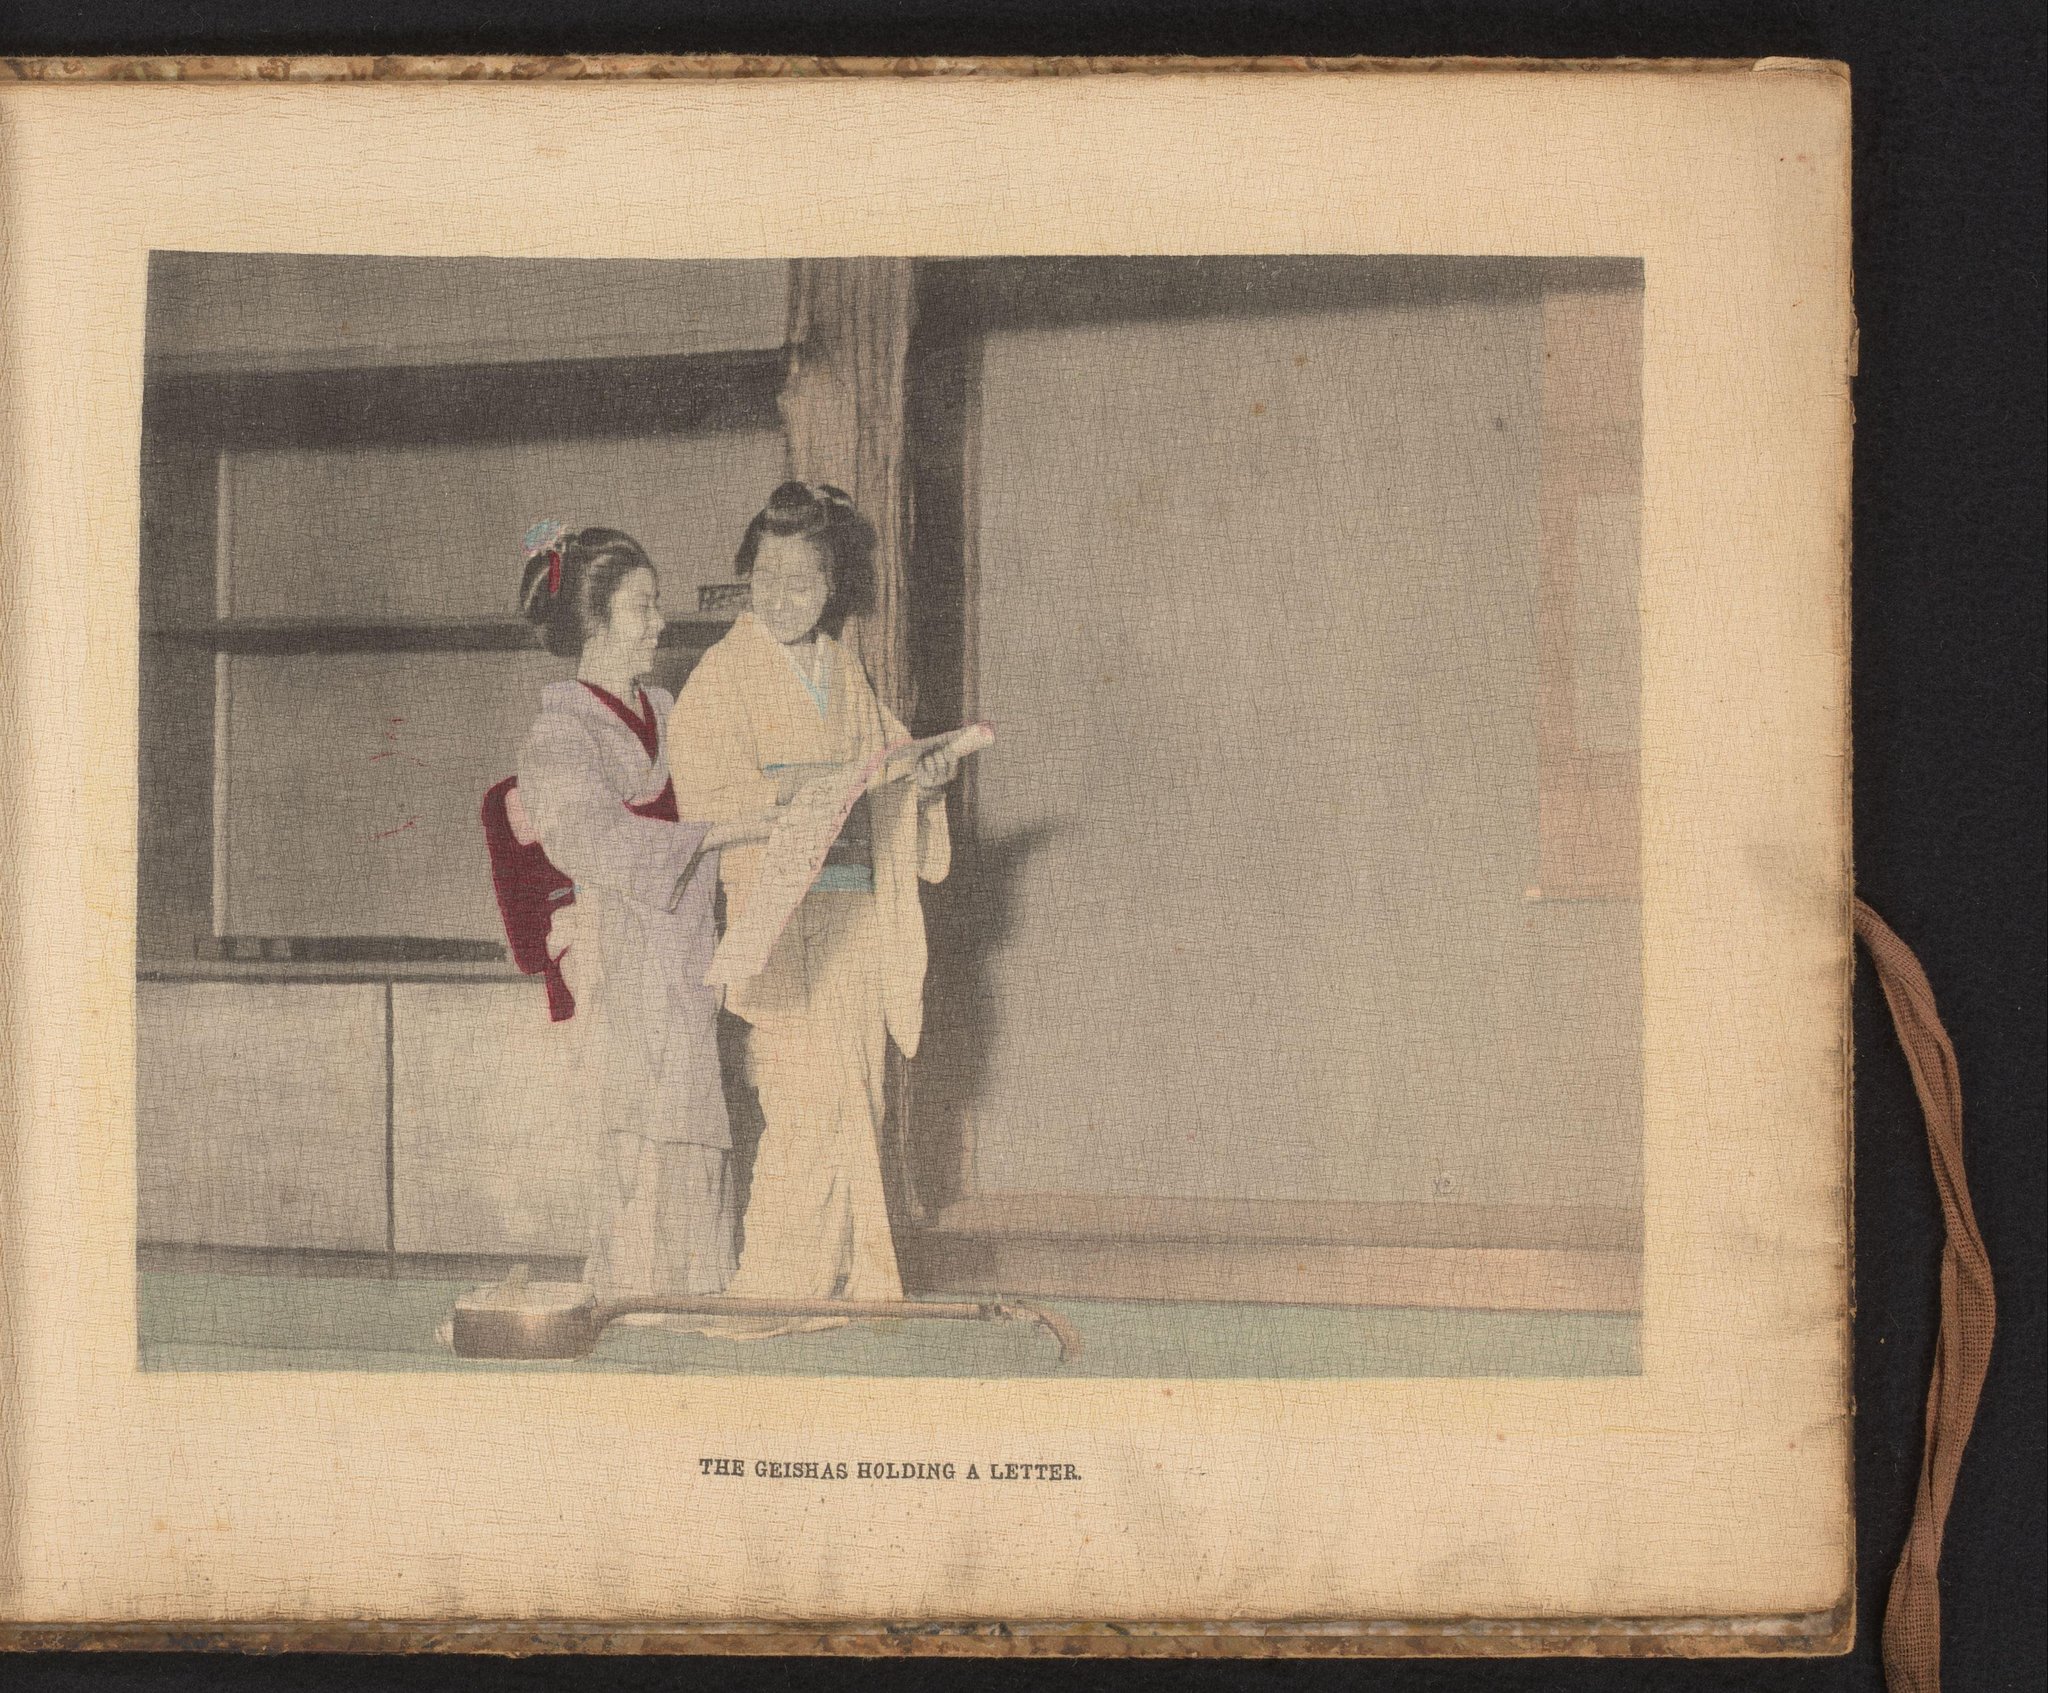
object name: photomechanical print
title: Picking tea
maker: Anonymous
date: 1891-1896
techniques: collotype process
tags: adult woman, reaping, picking, mowing ~ harvest, japan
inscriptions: inscription: ‘The girls squatting up and down the rows of little bushes are plucking off teh new budded leaflets which make the choicest tea of the year. [...]’